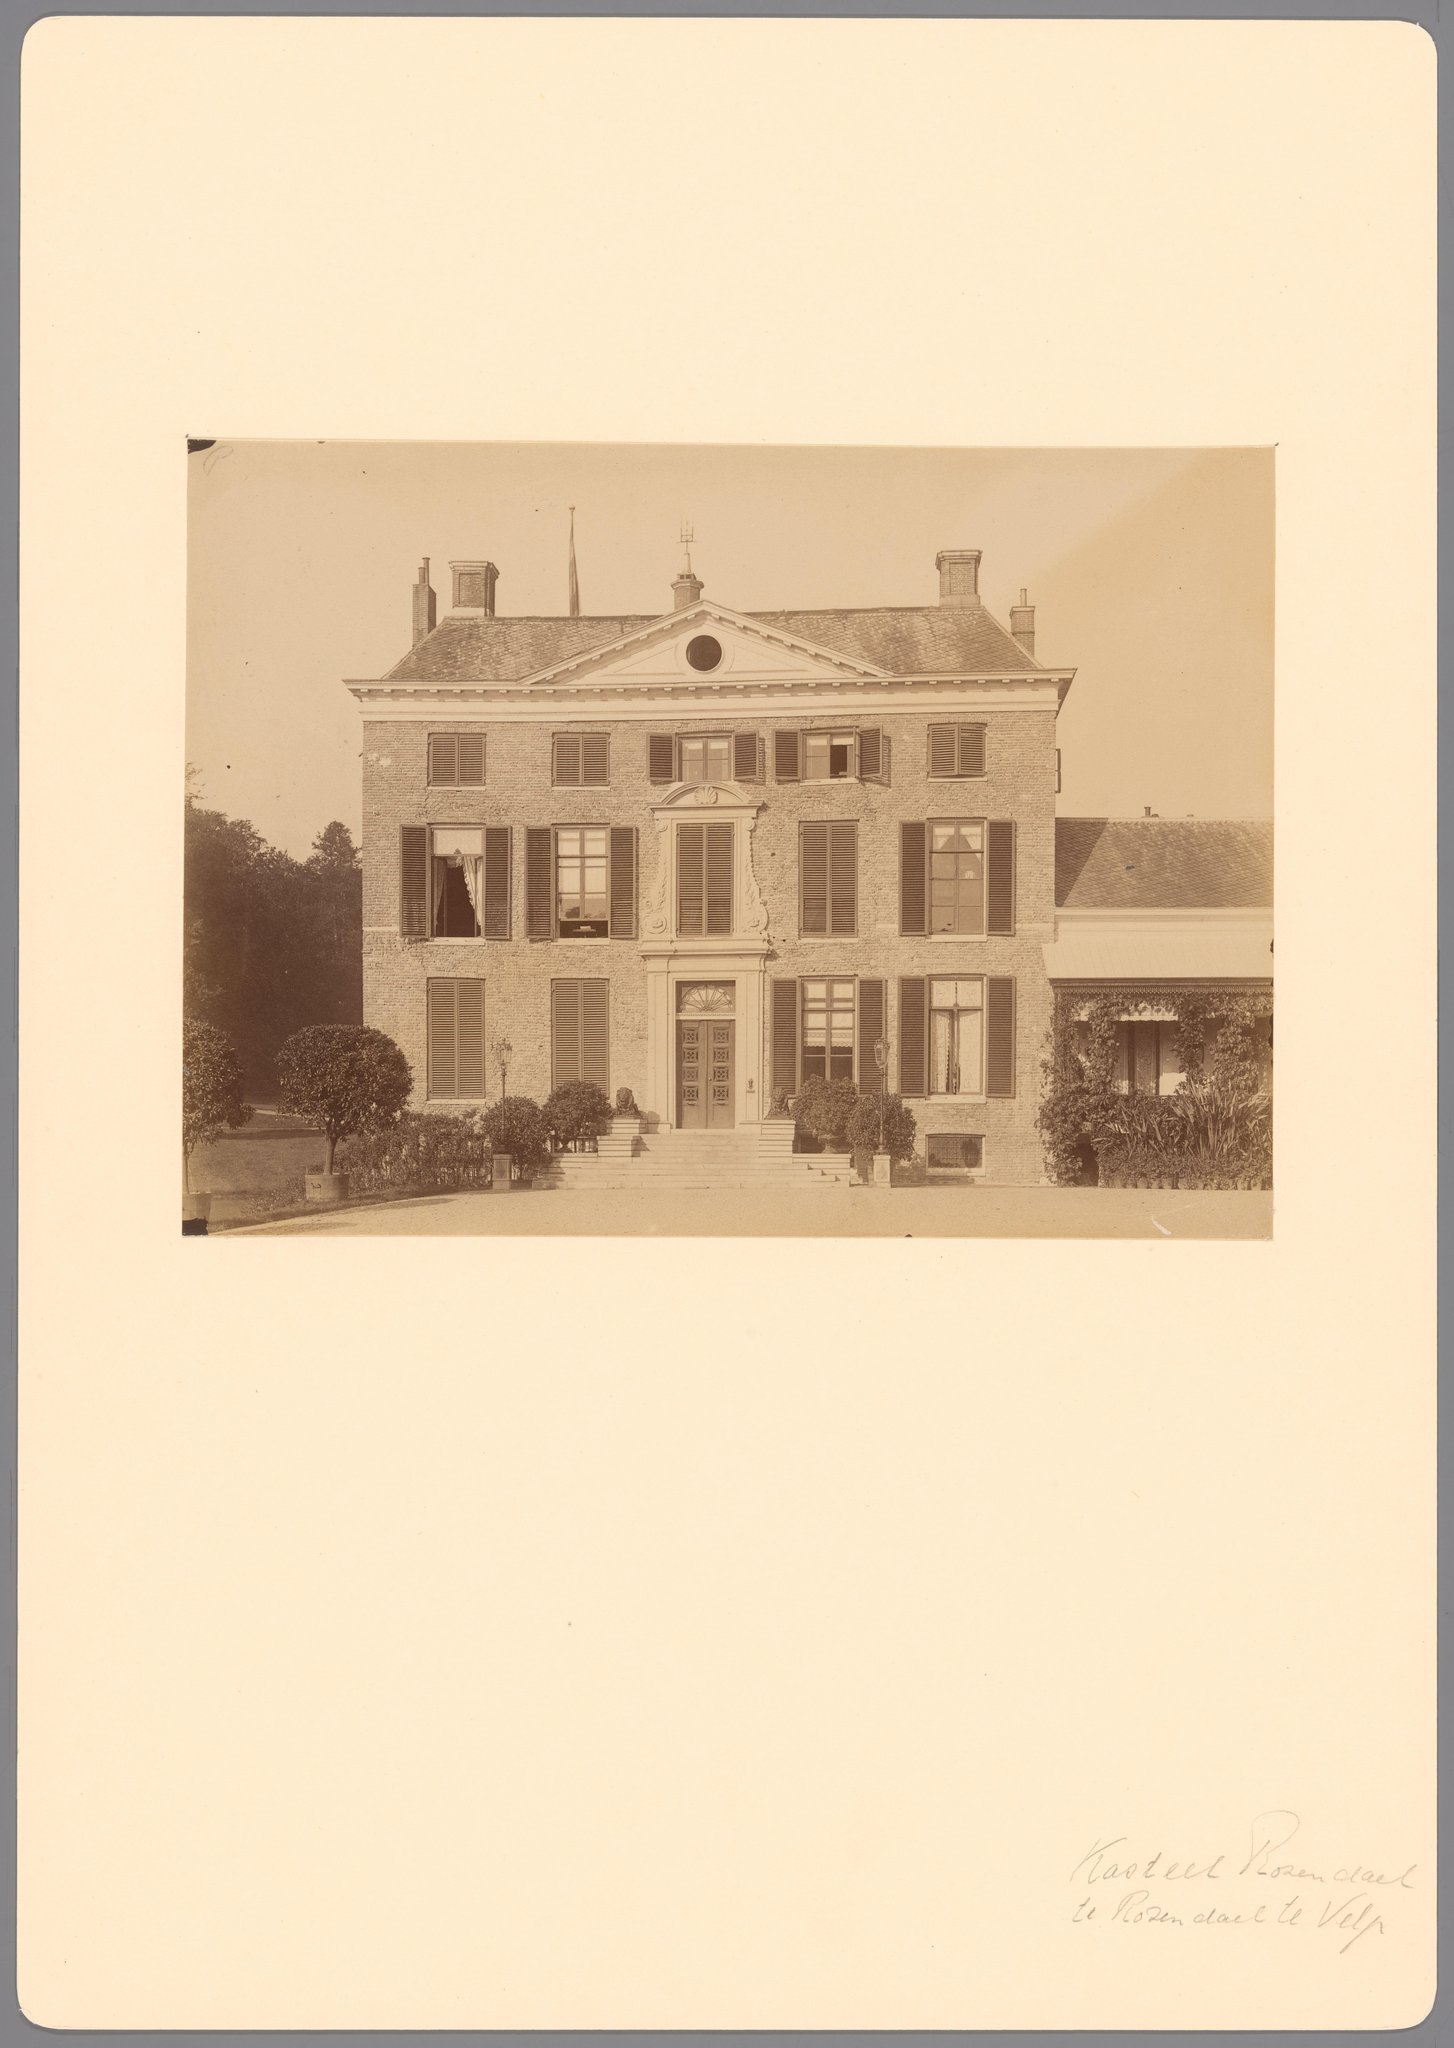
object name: photograph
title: Gezicht op Kasteel Rozendael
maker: anoniem (monumentenzorg)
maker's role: fotograaf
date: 1890-1920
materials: cardboard, photographic support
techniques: albumen print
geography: rozendaal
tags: castle, landscape with tower or castle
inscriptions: annotation: ‘P/ Kasteel Rozendael te Rozendael bij Velp’